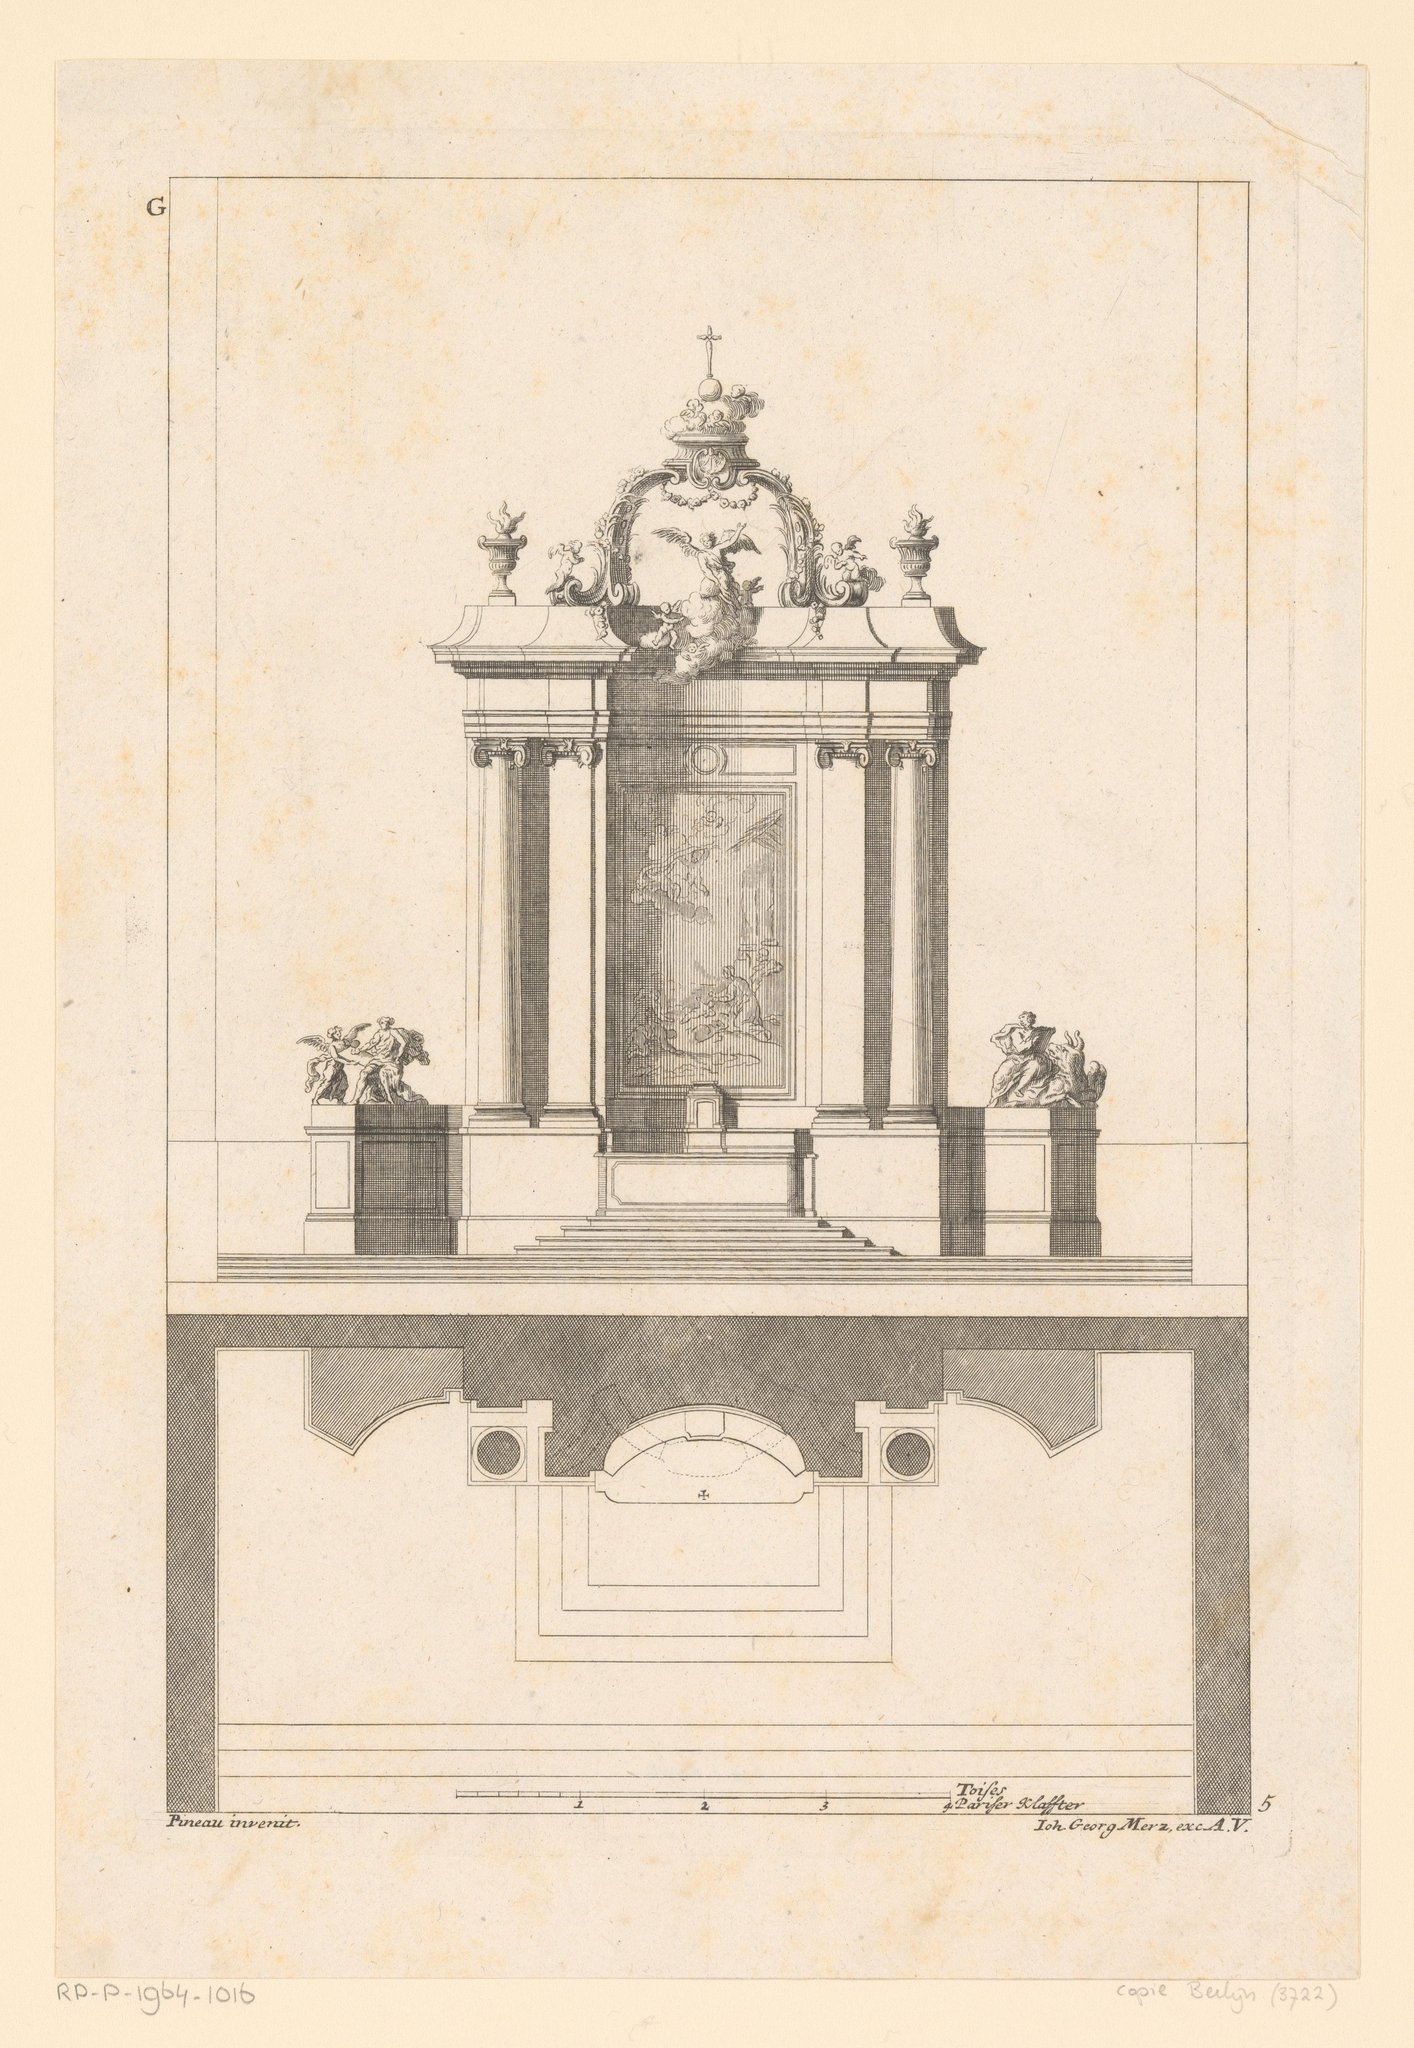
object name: ornament print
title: Altaar met evangelisten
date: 1704-1762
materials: paper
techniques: engraving, etching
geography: augsburg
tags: luke the evangelist; possible attributes: book, (winged) ox, portrait of the virgin, surgical instruments, painter's utensils, scroll, the apostle and evangelist matthew (mattheus); possible attributes: angel, axe, book, halberd, pen and inkhorn, purse, scroll, square, sword, altar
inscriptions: collector's mark: Lugt 2760, collector's mark: Lugt 2228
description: Vooraanzicht en plattegrond van een altaar met pilasters en een paneel met schildering. Daarboven vazen, engelen, putti en een kruis. Links en rechts de evangelisten Matteüs en Lucas.